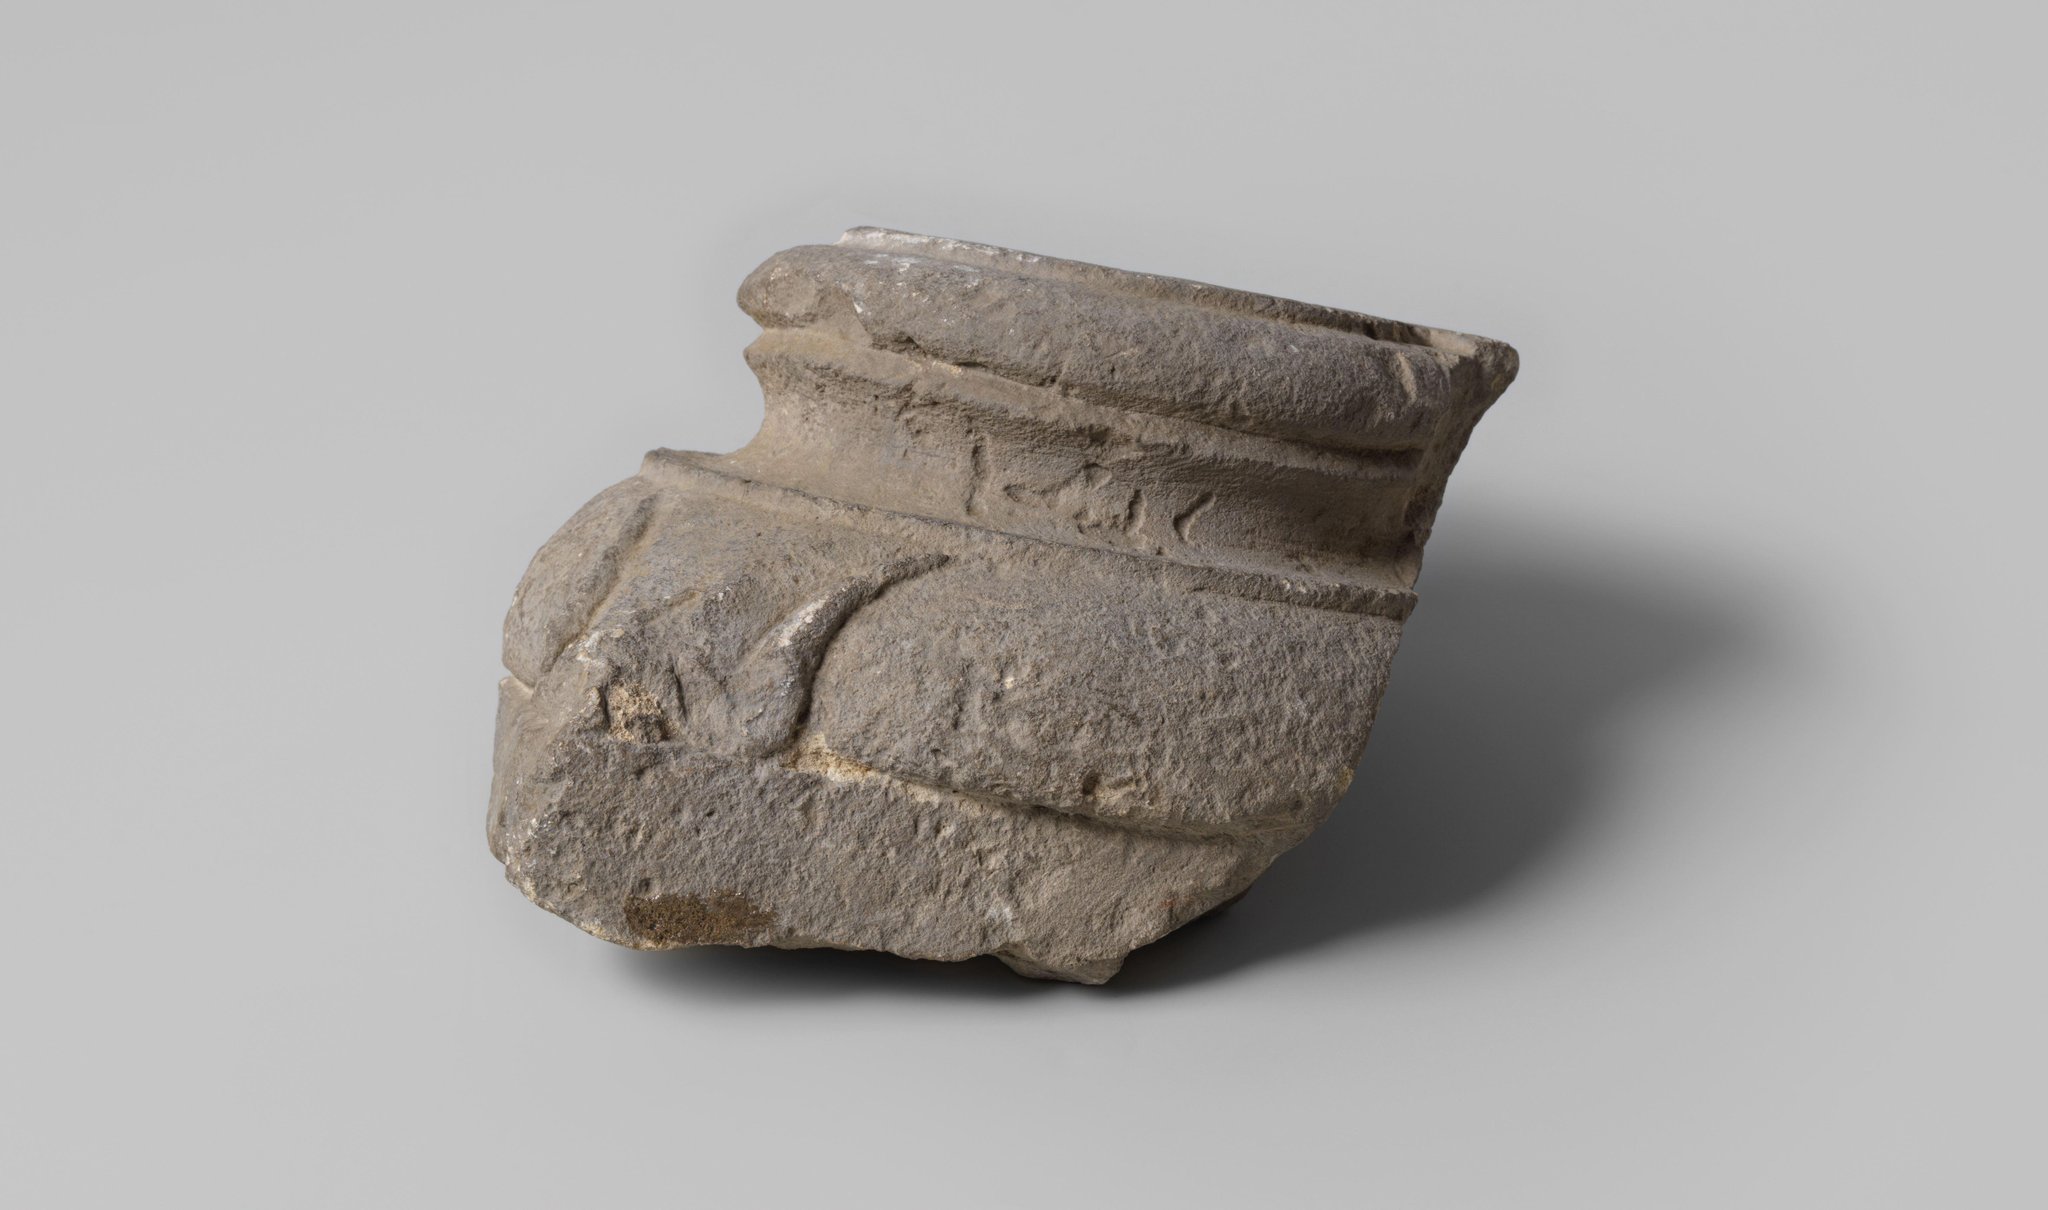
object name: architectural element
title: Basement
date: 1400-1950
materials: stone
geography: rolduc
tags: rolduc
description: Een romaanse basement met hoekspoor, afkomstig uit de kerk te Rolduc.